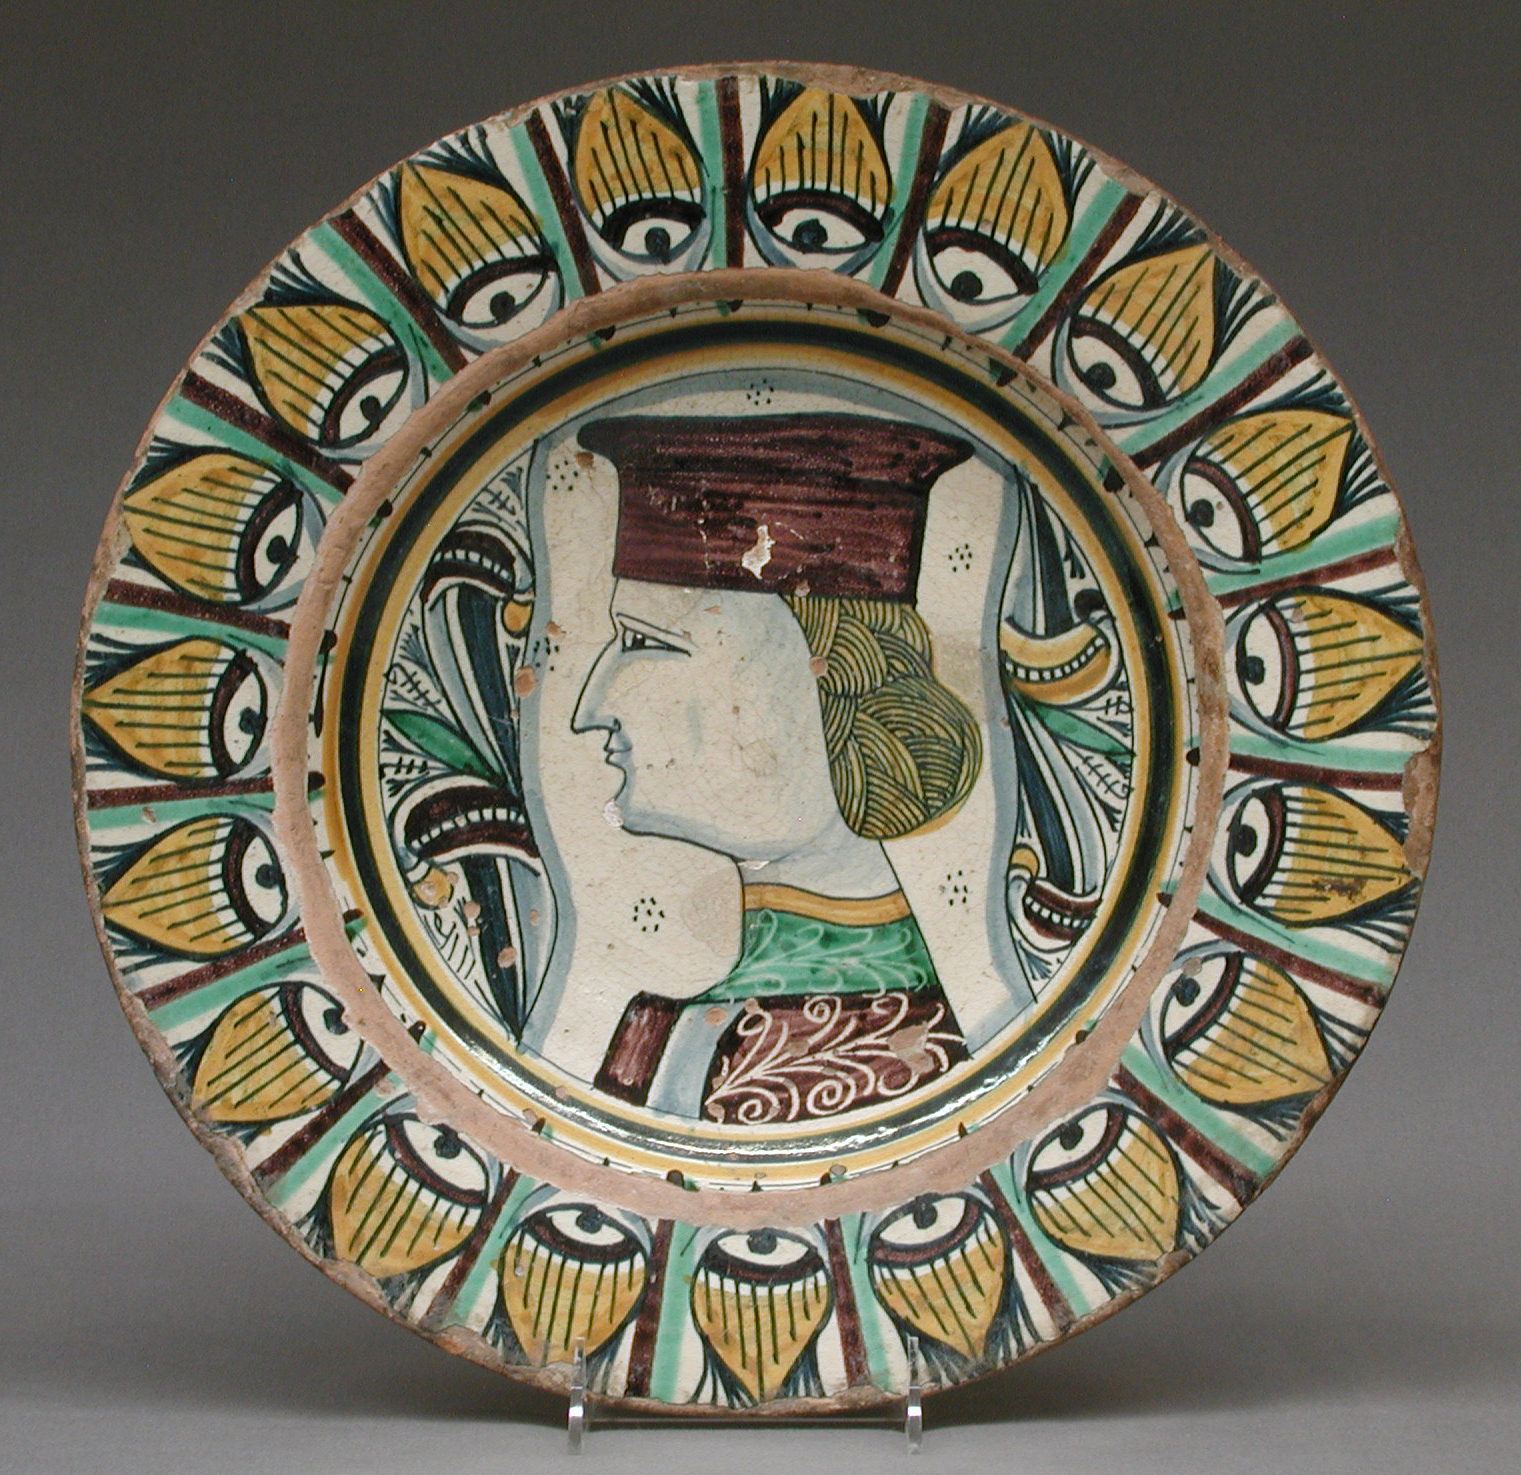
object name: dish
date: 1470-1480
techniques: maiolica, glazing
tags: men,profiles